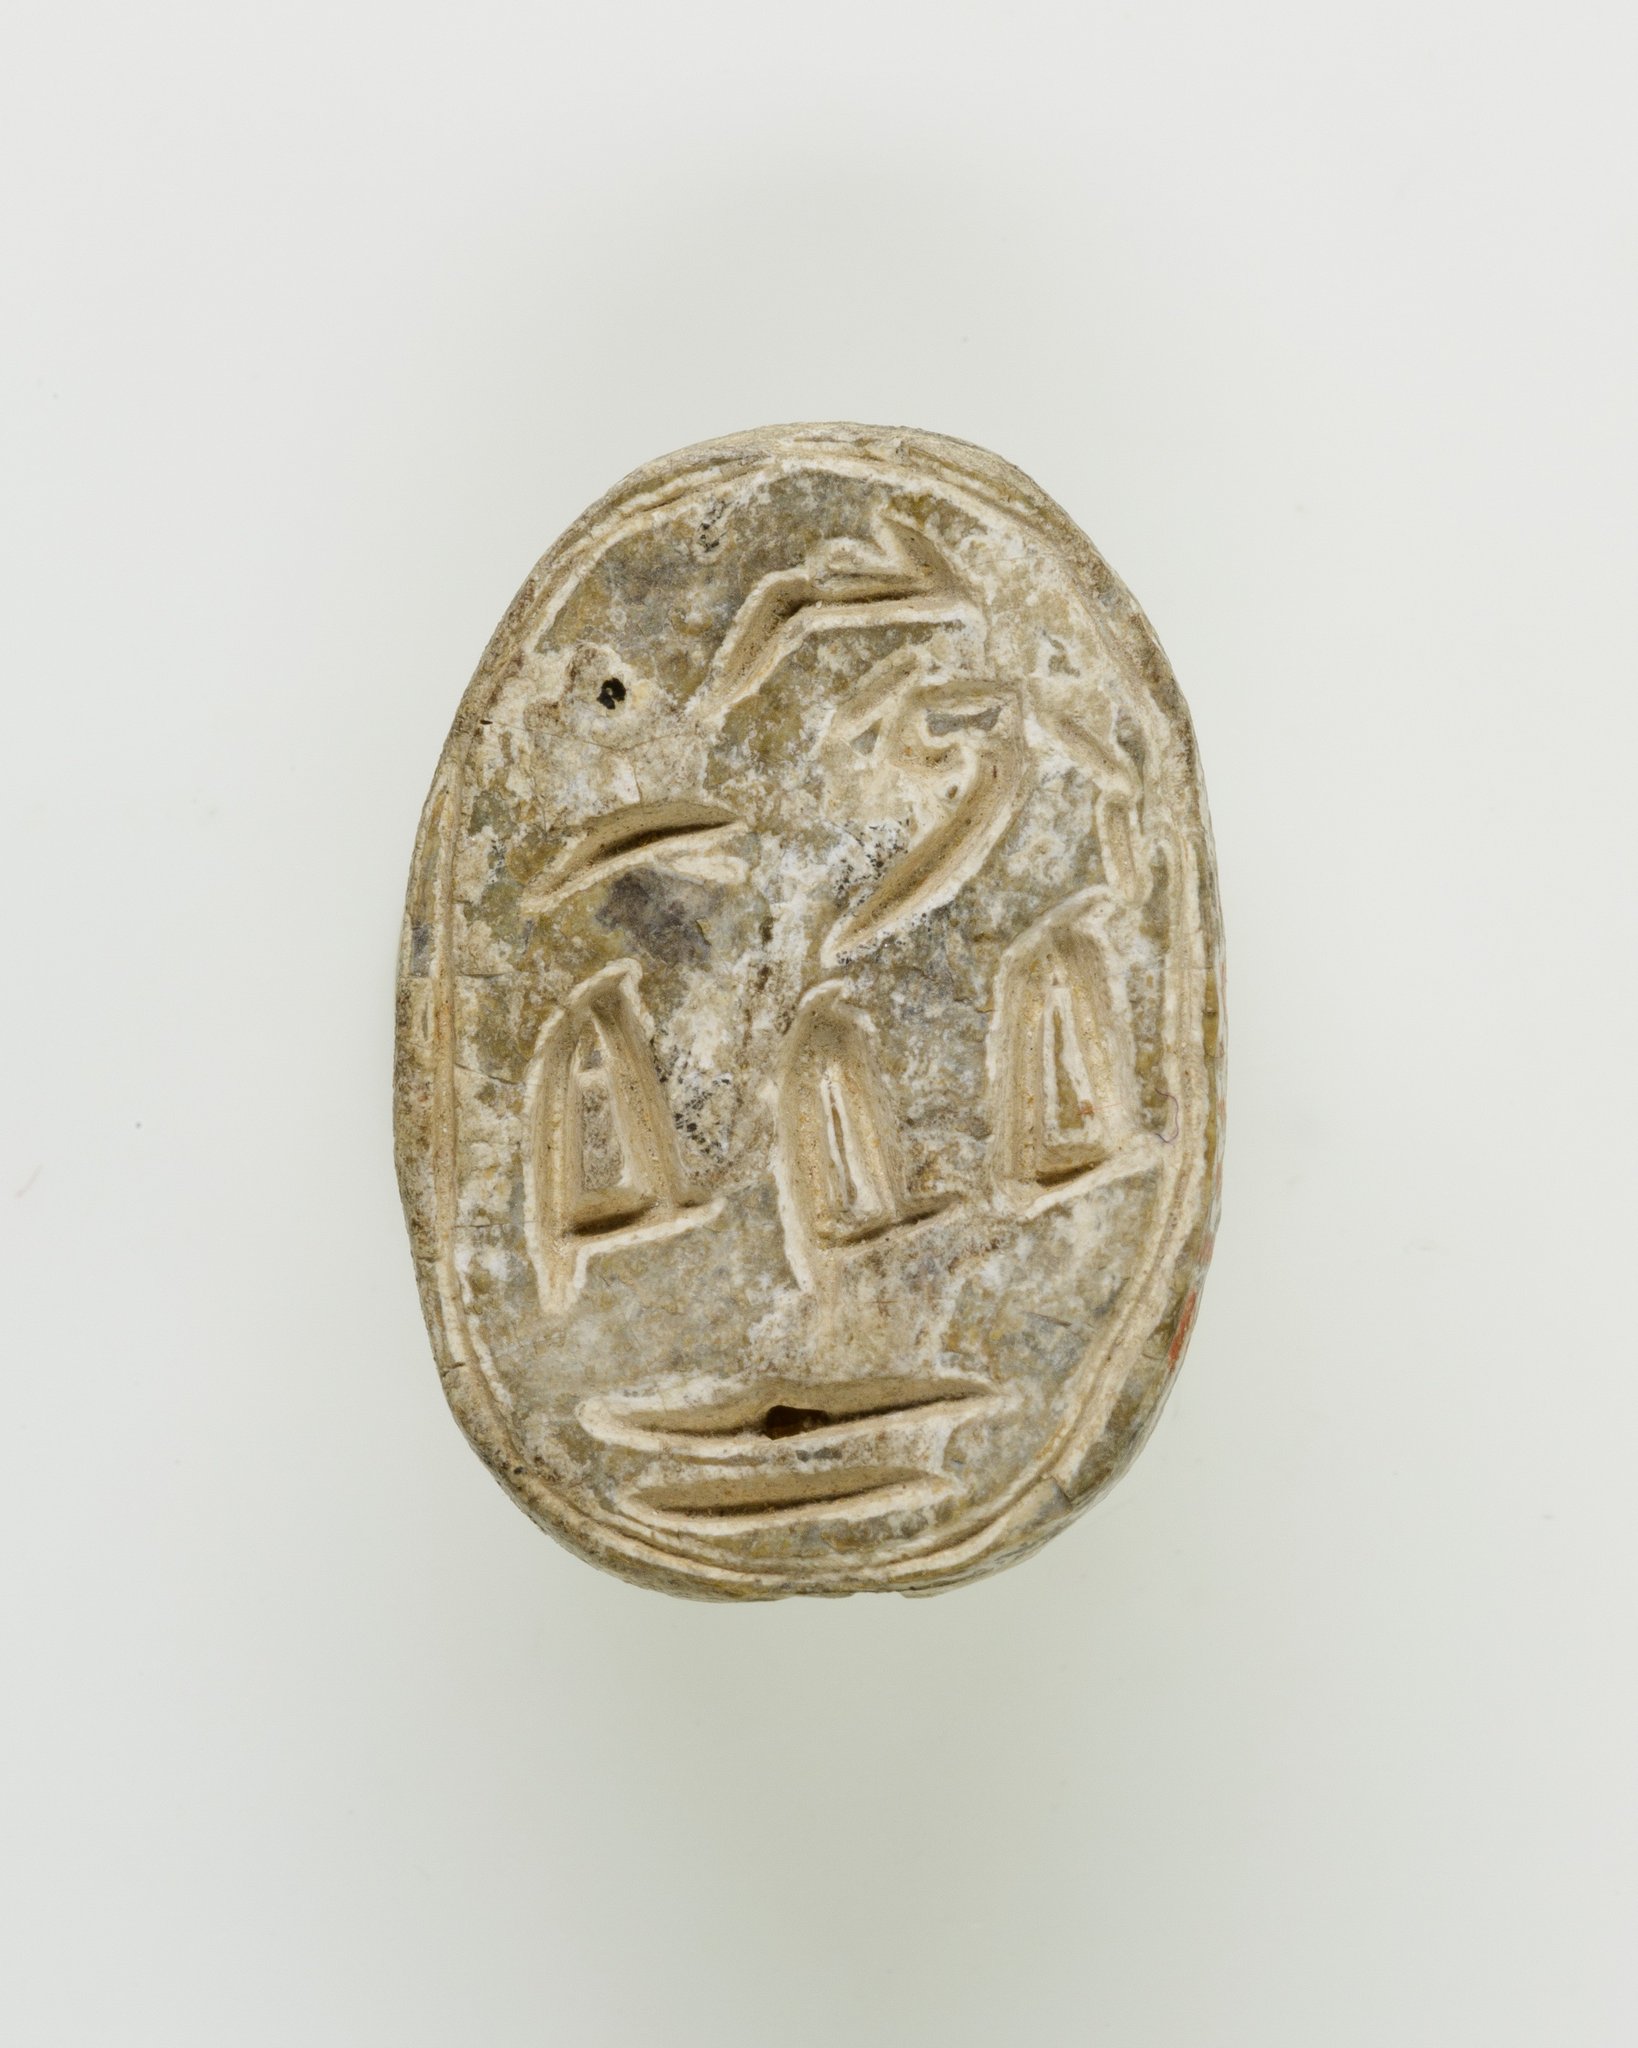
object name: scarab, official, private name and title, funerary epithet, ay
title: Scarab of an Official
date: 1740-1640 BCE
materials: stone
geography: egypt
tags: hieroglyphs,scarabs